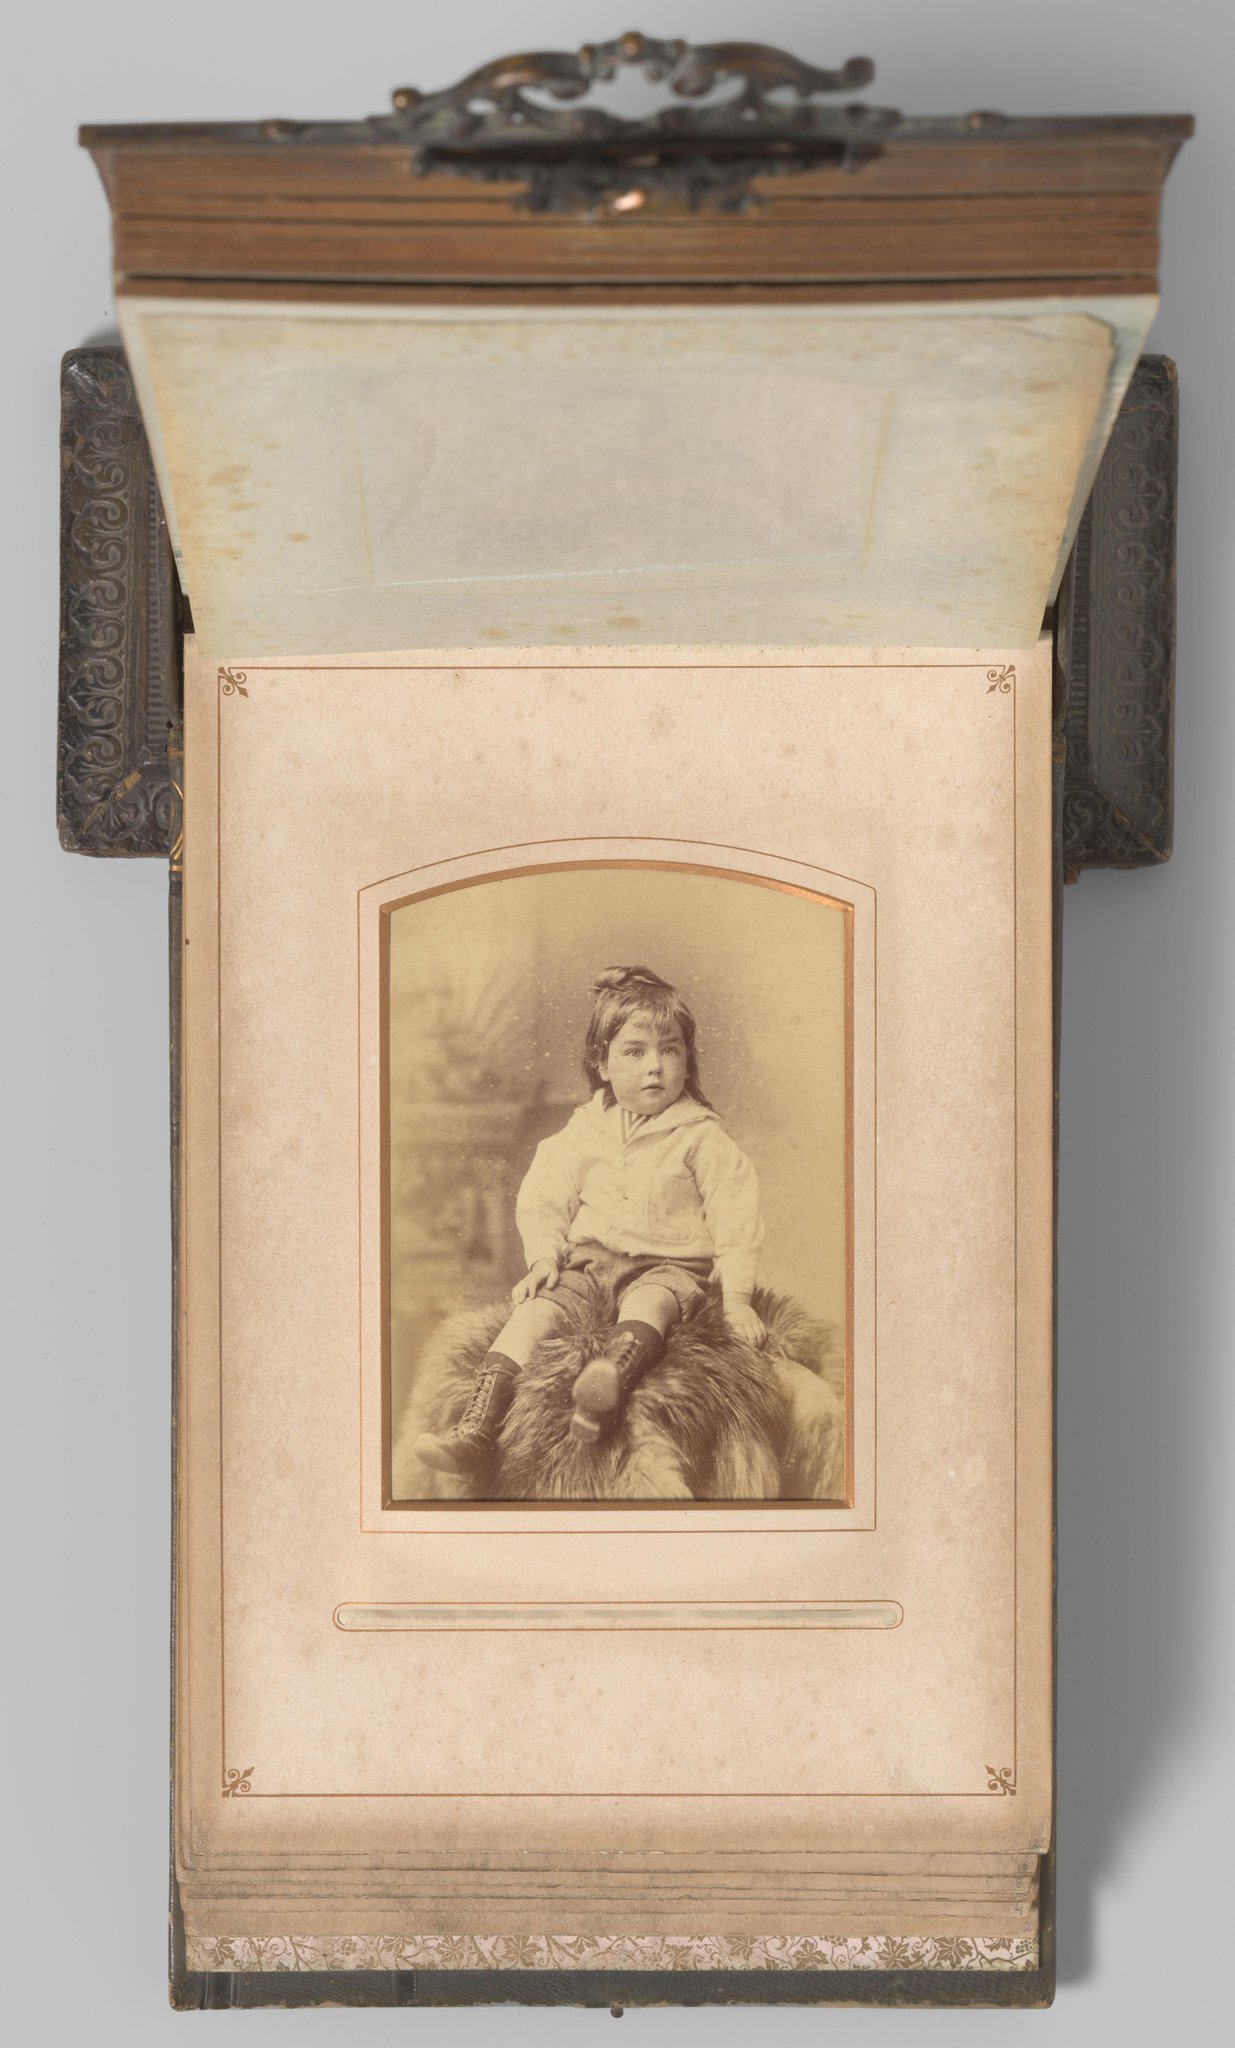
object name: album leaf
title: Portret van een zittend kind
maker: william hall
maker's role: fotograaf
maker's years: 1826-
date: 1887-1895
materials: cardboard, photographic support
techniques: albumen print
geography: brighton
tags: sitting figure, historical persons, tot, toddler ~ the ages of man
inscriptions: inscription: ‘(...)/ Special Apparatus for Out-doos Photography./ Family. Marriage. Pic-Nic, & c. other Groups/ Equestrian Portraits, Houses, Ships/ W. HALL & SON/ Machinery, Animals & c. & c./ Pictures, finished, framed & c./ Brighton/ 80, West Street.’